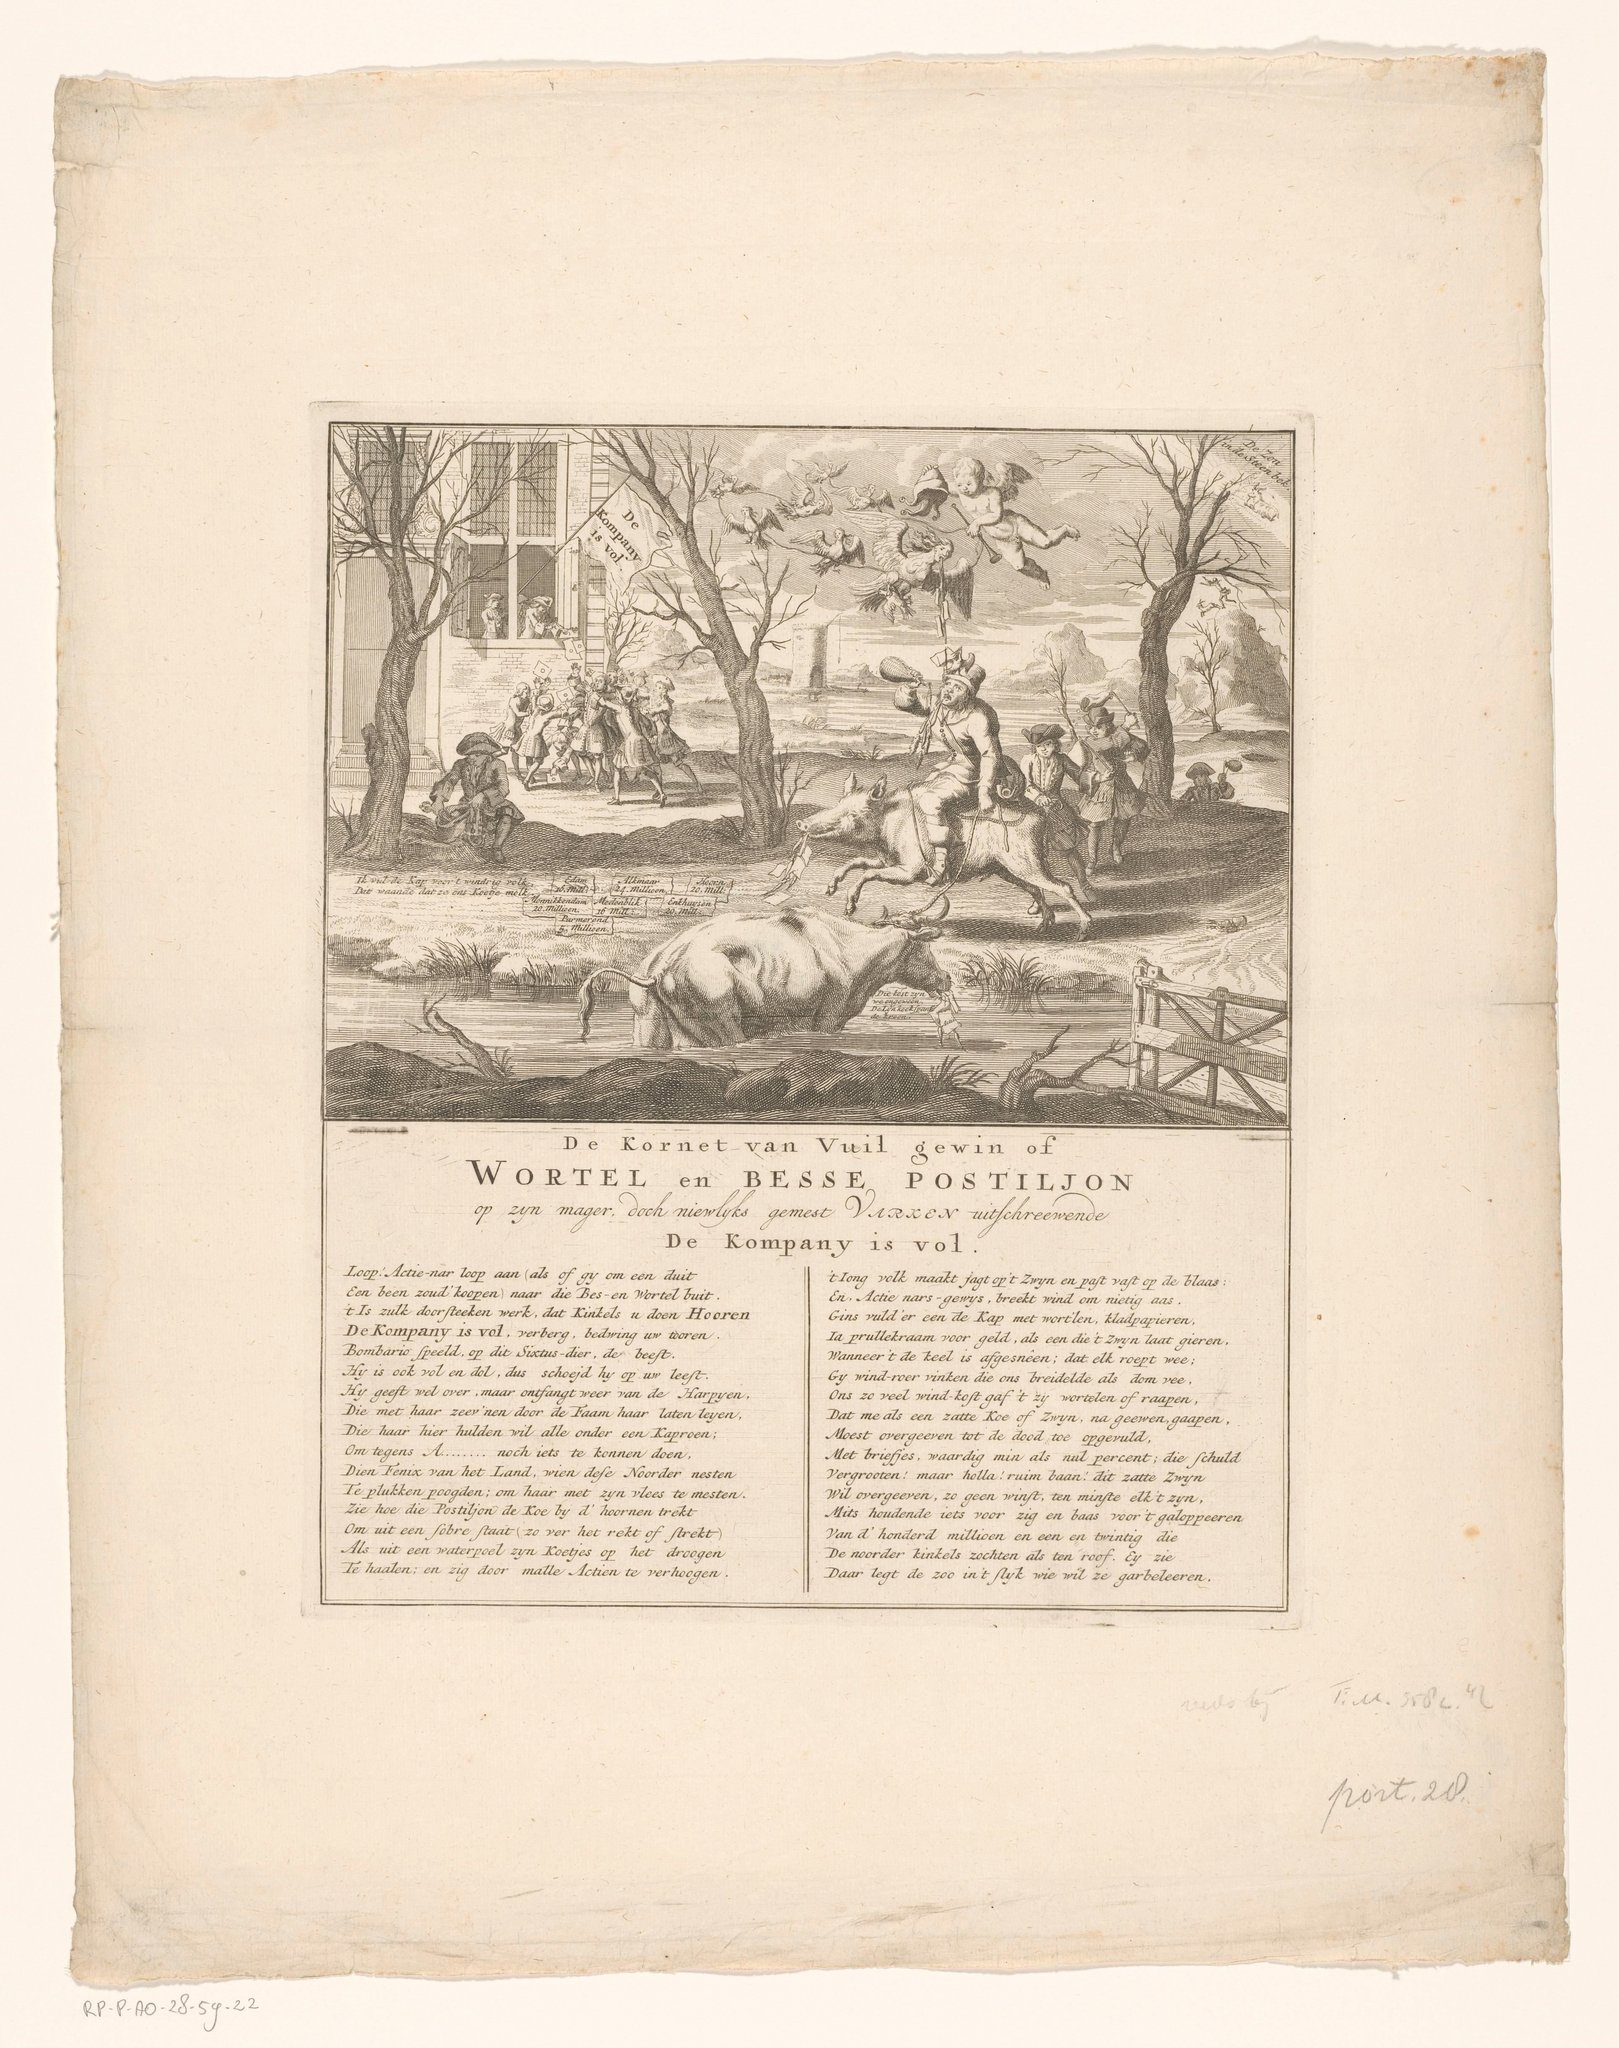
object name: cartoon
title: Het Groote Tafereel der Dwaasheid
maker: Anonymous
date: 1720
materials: paper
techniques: engraving, etching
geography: northern netherlands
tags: messenger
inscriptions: collector's mark: Lugt 2228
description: Een postiljon op een varken verspreidt het nieuws dat de compagnie vol is. Op de voorgrond kauwt een koe in een sloot op de waardeloze aandelen. Links op de achtergrond verdringen windhandelaren zich bij de uitgifte van aandelen. In het onderschrift een vers in twee kolommen. Prent 47 in de serie Het Groote Tafereel der Dwaasheid met spotprenten op de Windhandel of Actiehandel van 1720.